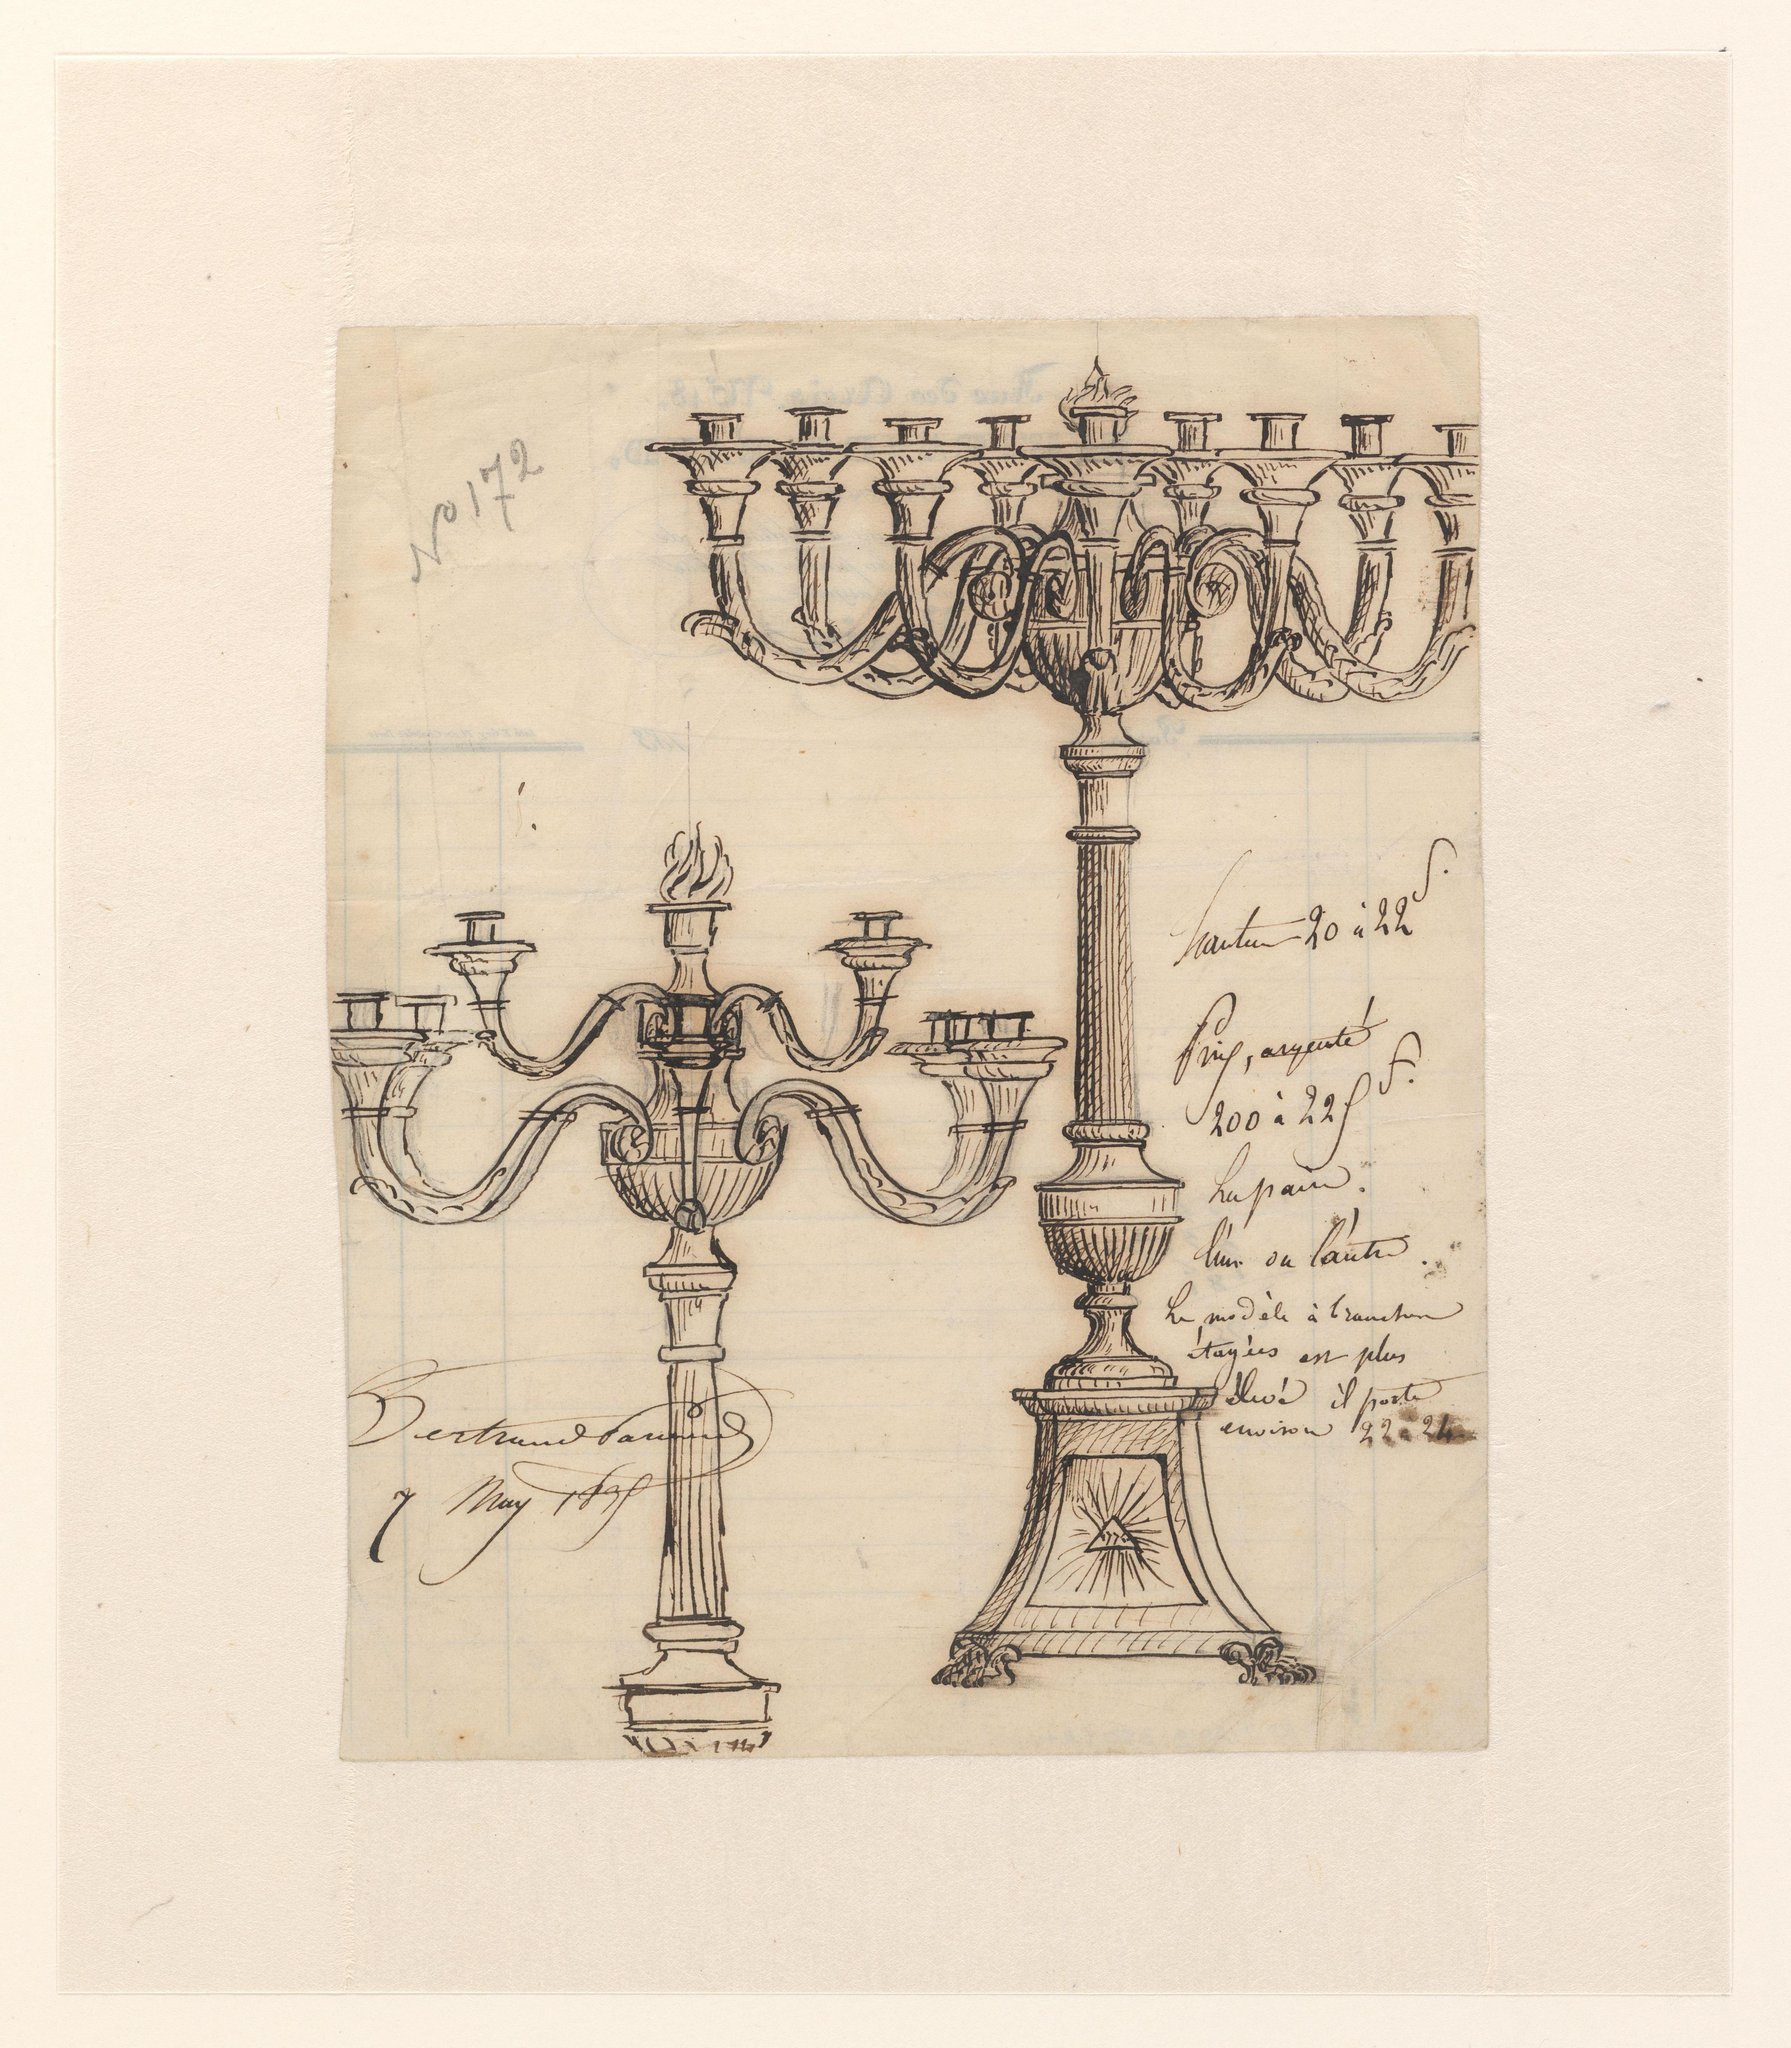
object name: design drawing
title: Twee ontwerpen voor kandelabers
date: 1835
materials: graphite, ink, paper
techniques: pen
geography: france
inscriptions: number: ‘No 172’, signature and date: ‘Bertrand Paraud / 7 May 1835. Opschrift in pen en bruine inkt: hauteur 20 à 22 ~ / Prix, argenté / 200 à 225 ~ / La paire. / l’un ou l’autre / Le modèle à branches / étagées est plus / élevé il porte / environ 22 a 24’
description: Getekend op de achterzijde van gegraveerd factuurpapier van Bertrand-Paraud (RP-T-2019-350(V)).